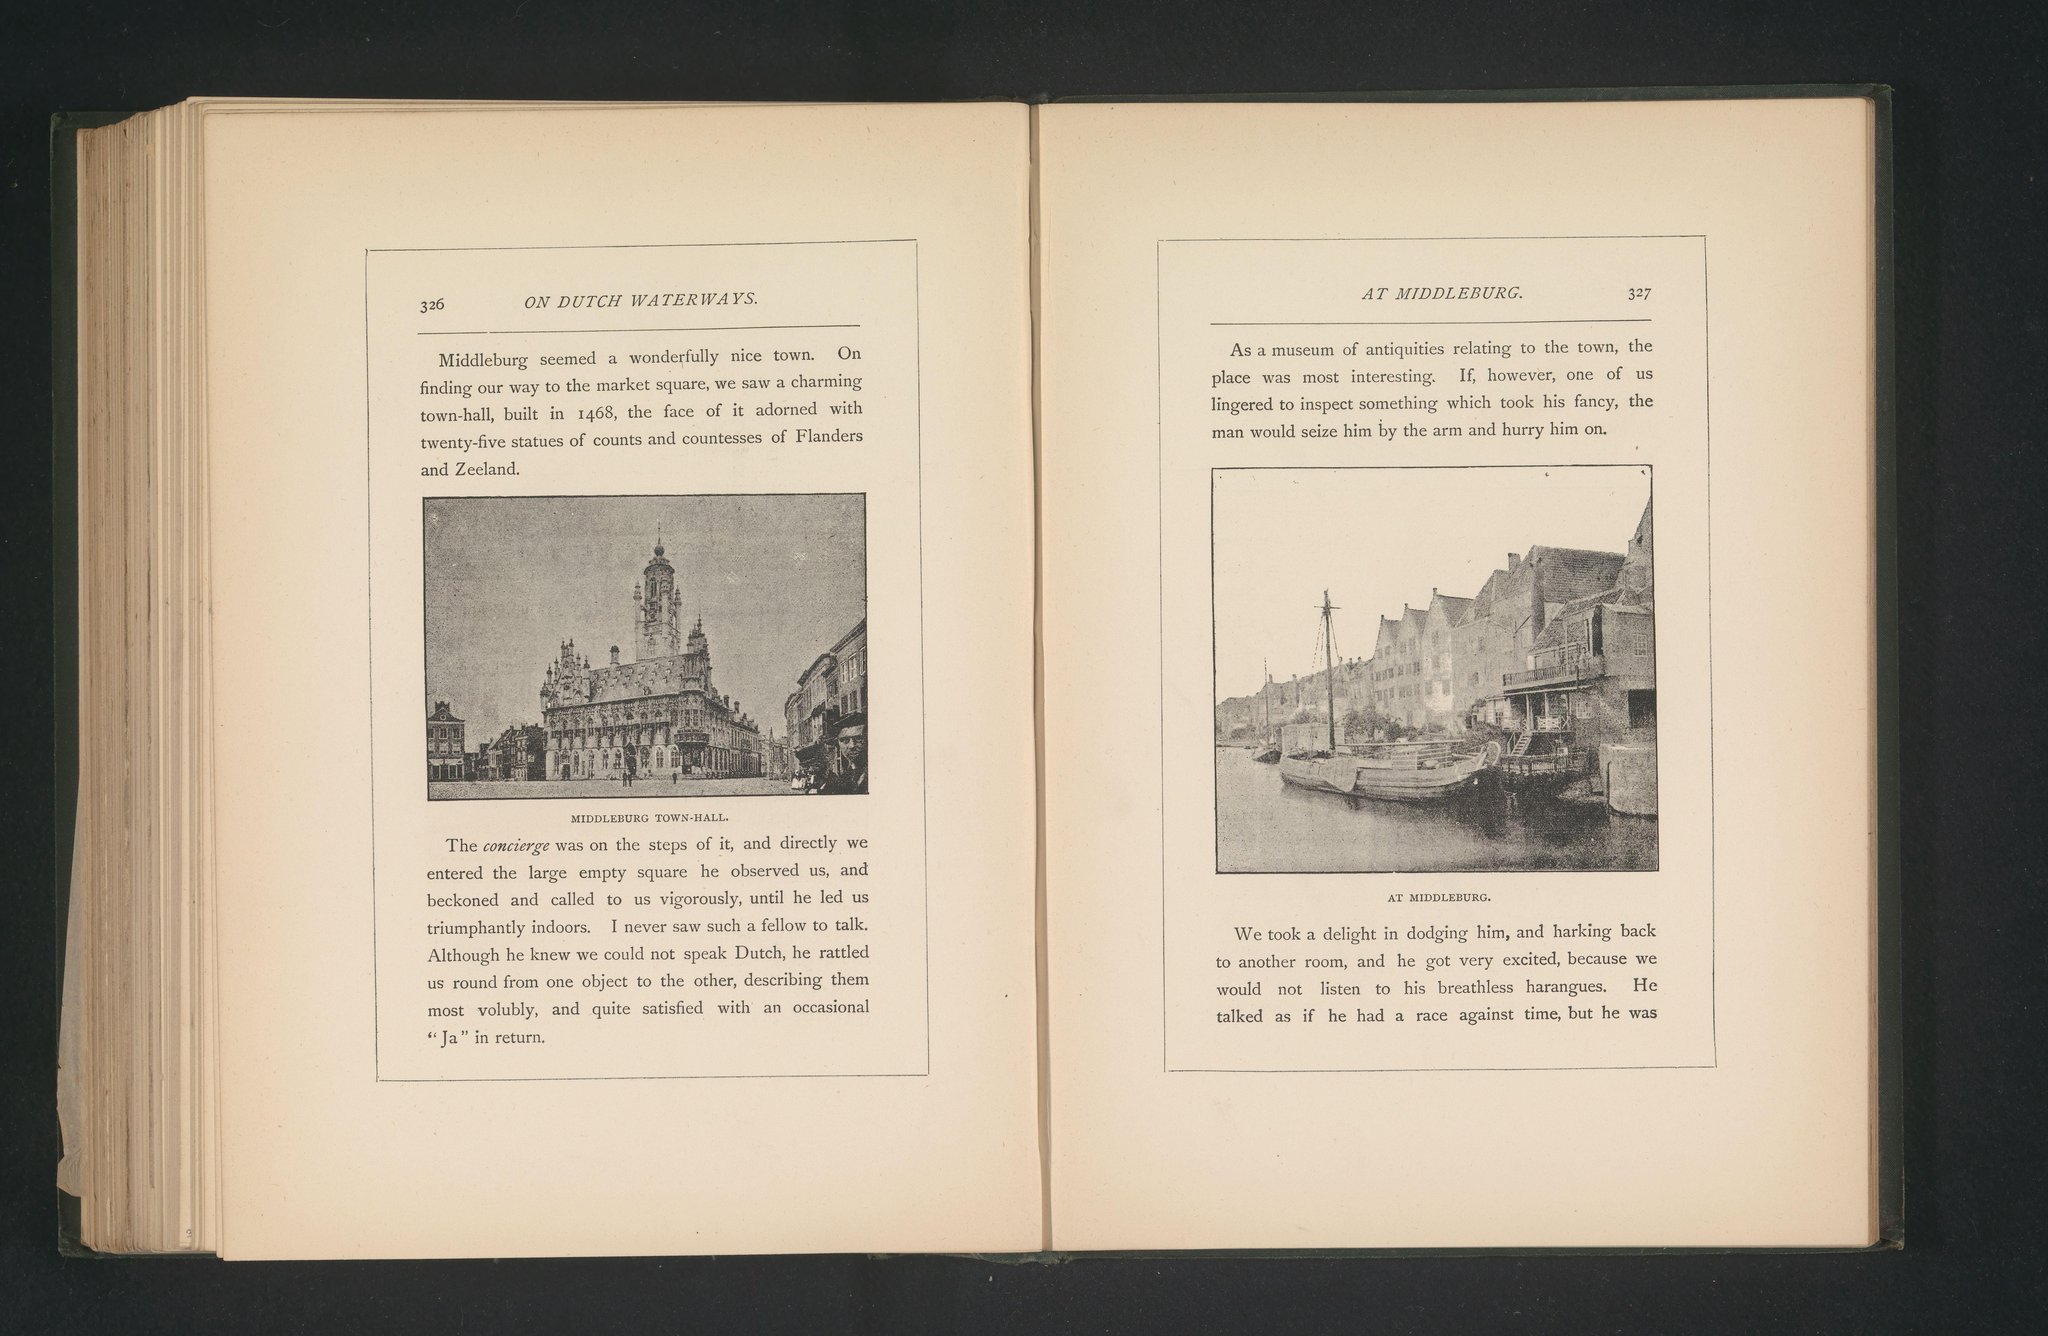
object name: photomechanical print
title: Gezicht op een aangemeerd zeilschip in Middelburg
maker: george christopher davies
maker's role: fotograaf, geoloog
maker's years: 1849-1922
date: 1881-1886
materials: paper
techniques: autotype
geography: london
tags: sailing-ship, sailing-boat, the usual house or row of houses, middelburg